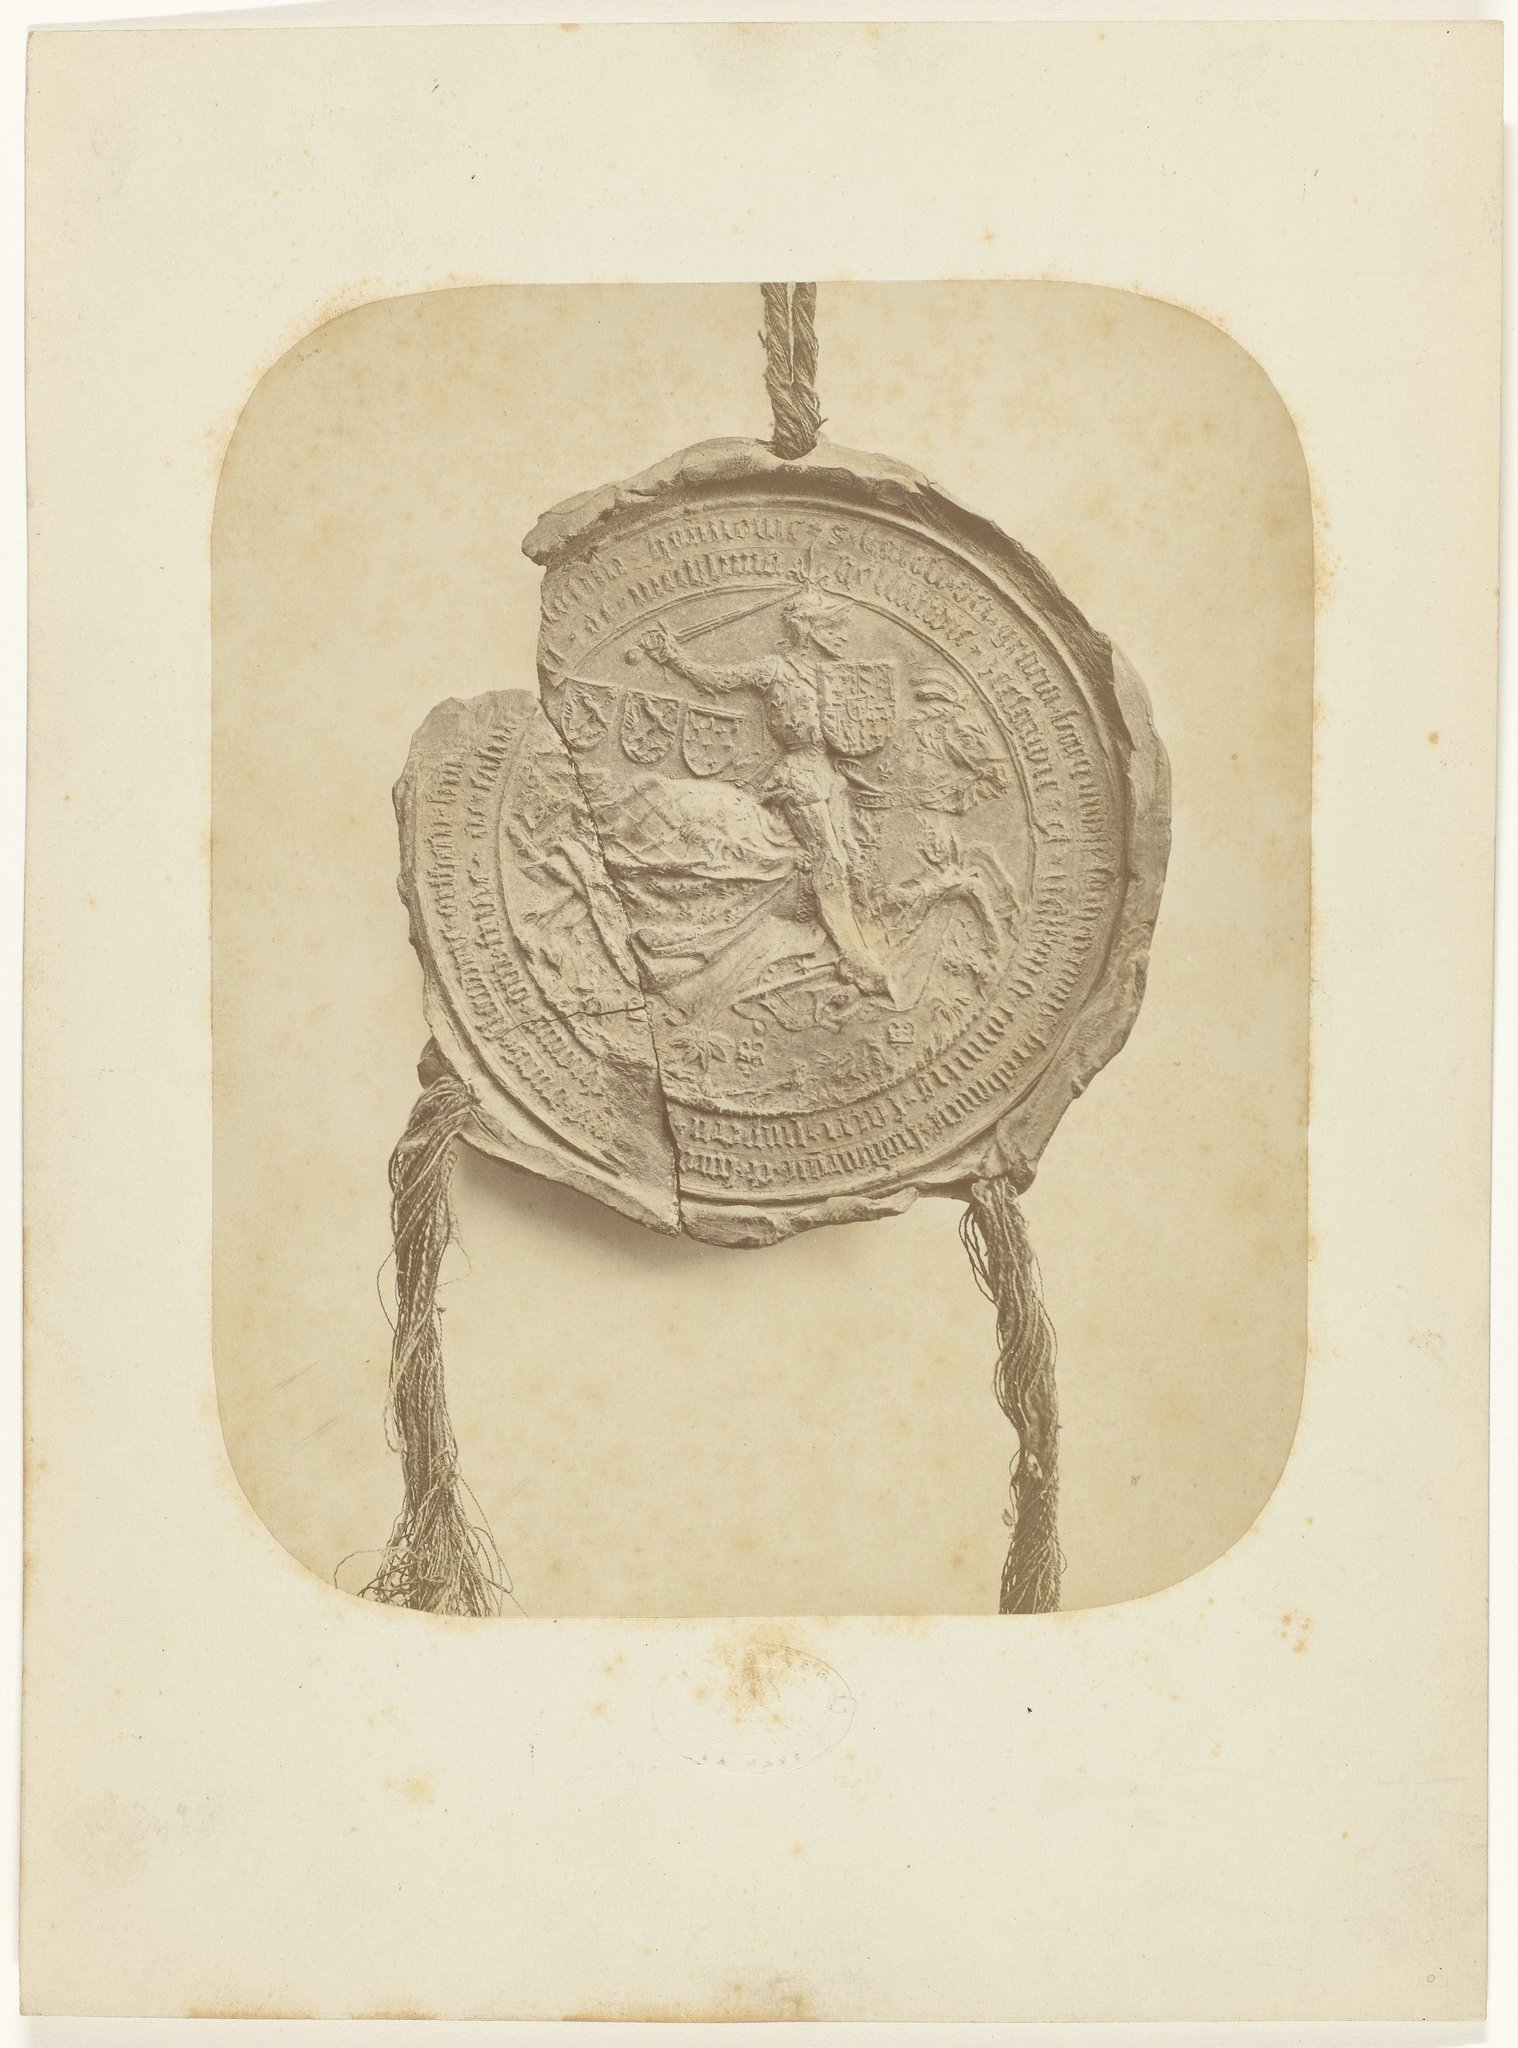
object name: photograph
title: Reproductie van een zegel van een onbekend historisch document, mogelijk betrekking hebbend op Karel de Stoute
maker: maurits verveer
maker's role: painter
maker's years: 1817-1903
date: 1865-1885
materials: paper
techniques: albumen print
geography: the hague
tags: earl, charles the bold (duke of burgundy), seal, stamp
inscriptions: annotation: ‘Karel de Stoute’, check stamp: ‘M. VERVEER // LA HAYE // PHOTOGRAPHE // DE S.M. // LE ROI DES PAYS BAS’, date: ‘20 Oct 1469’